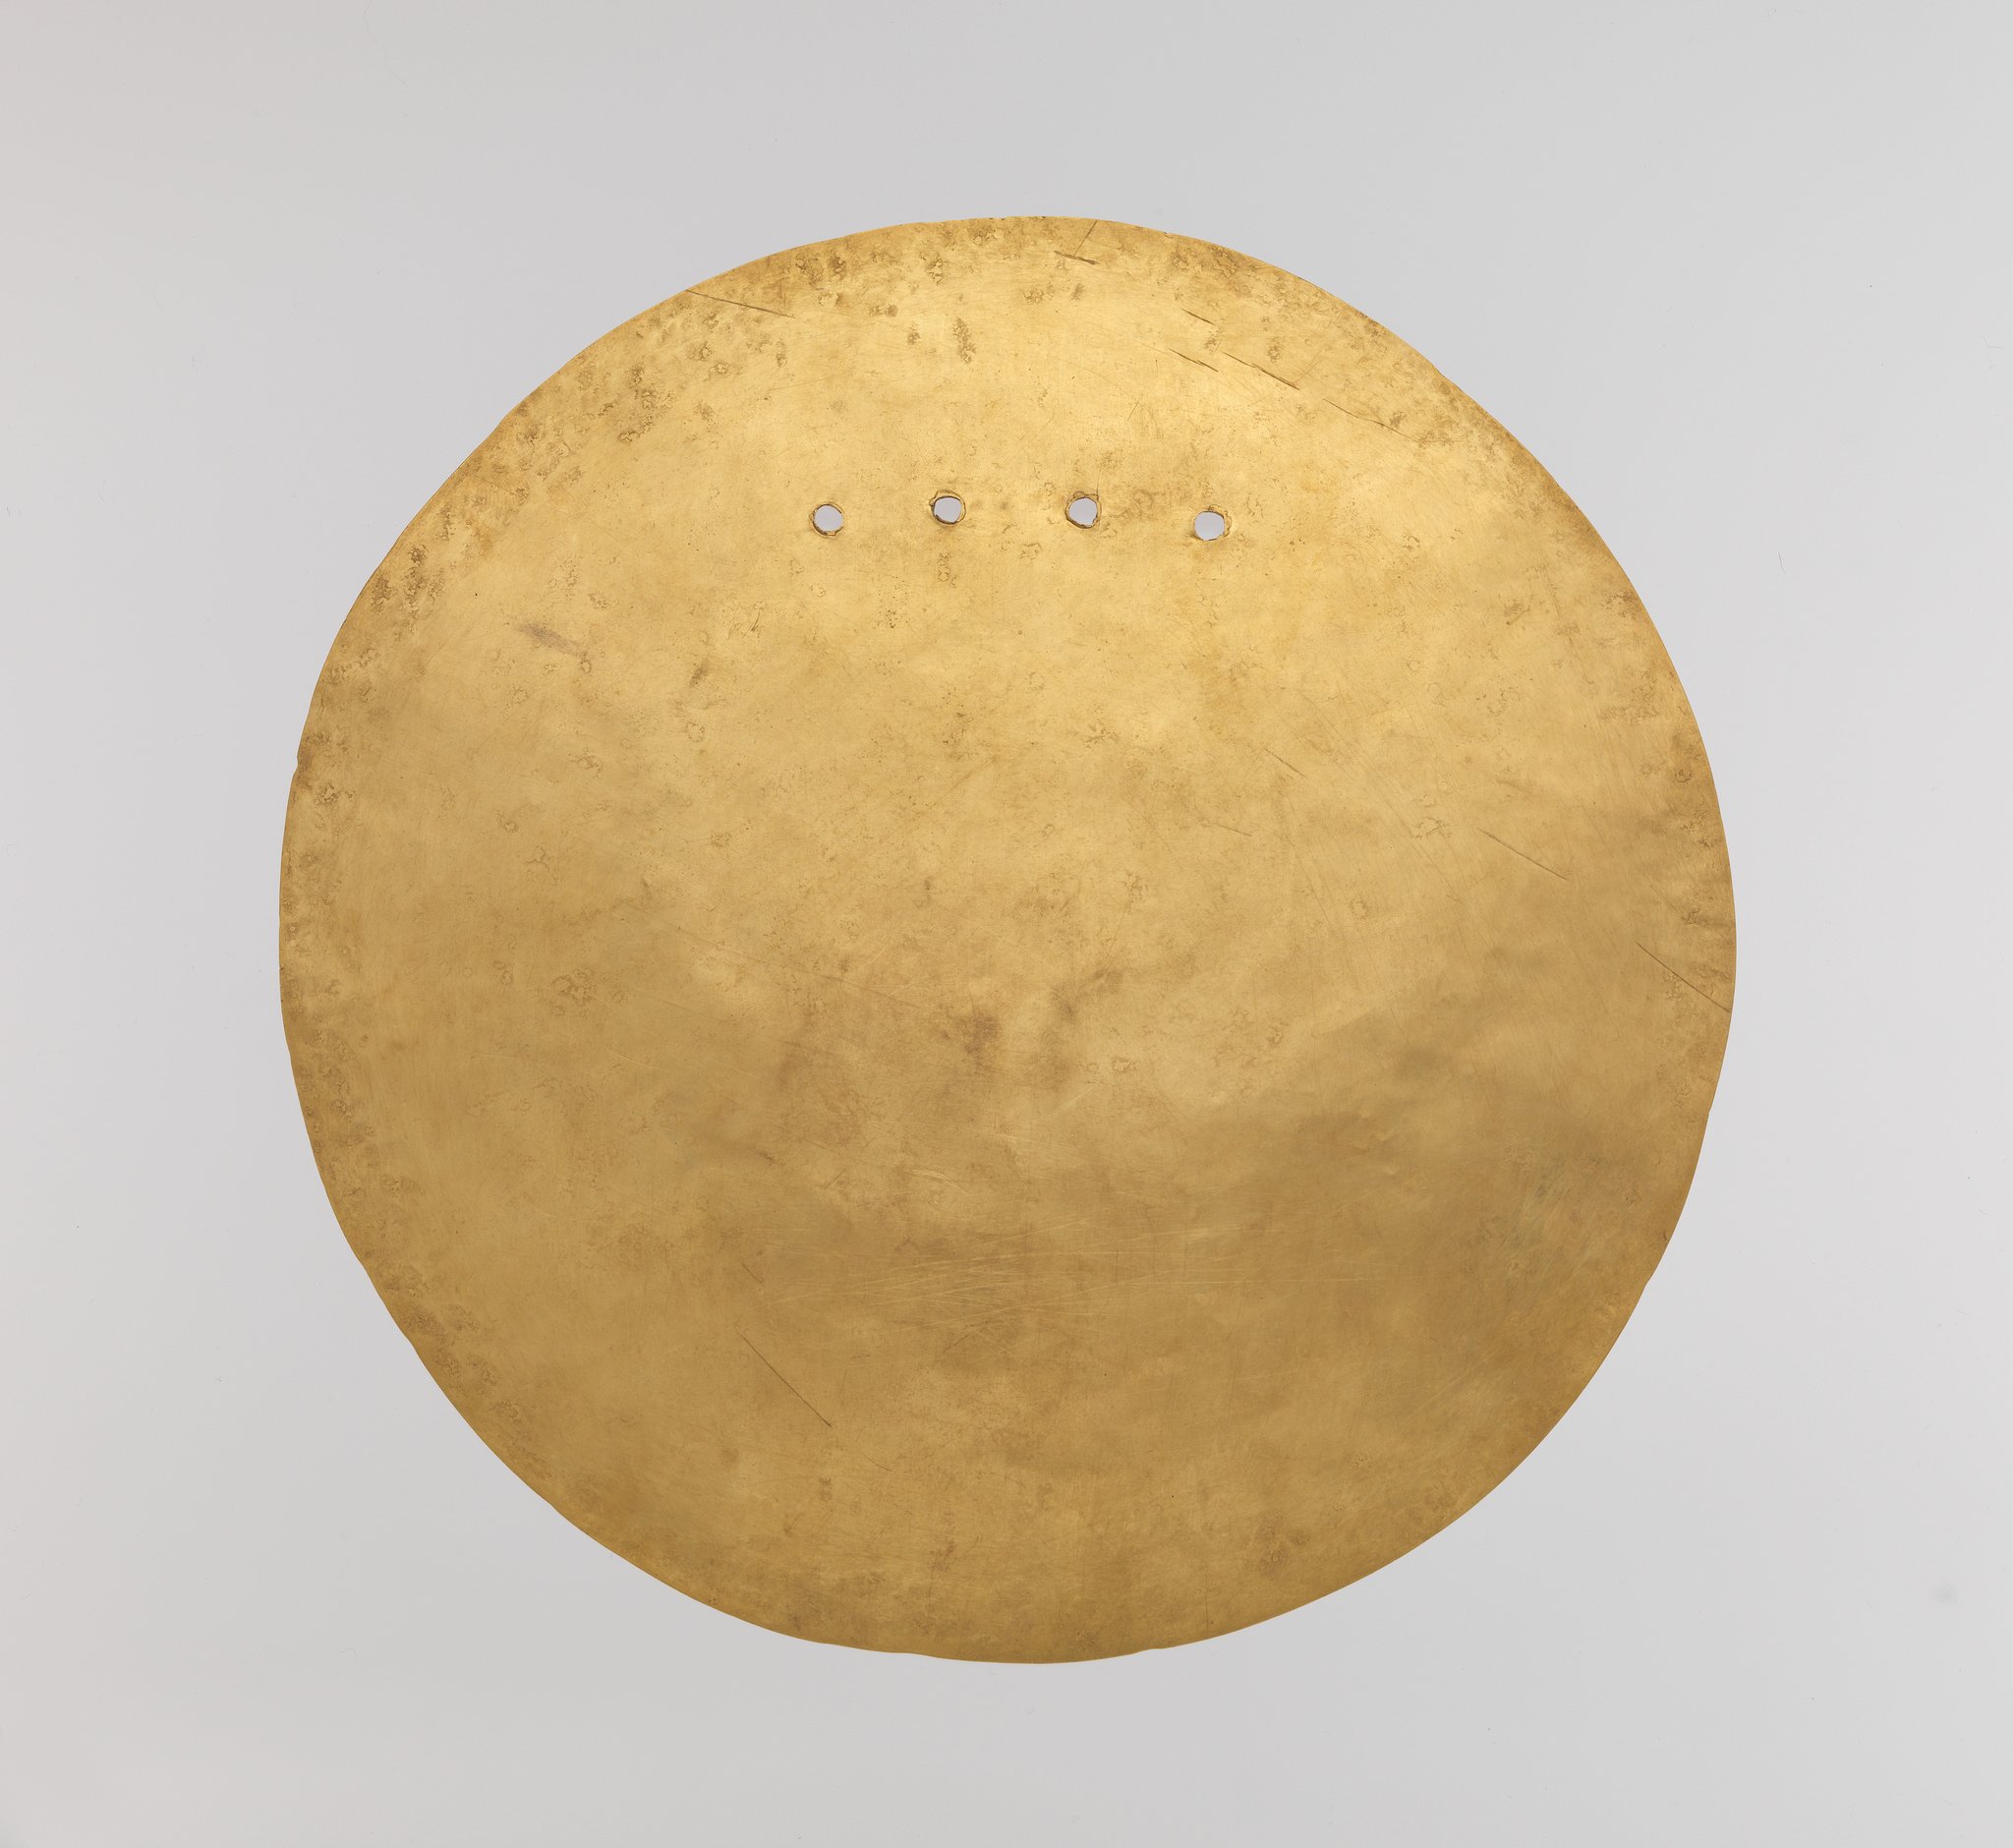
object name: pectoral disk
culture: capulí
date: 601-1200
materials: gold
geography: colombia